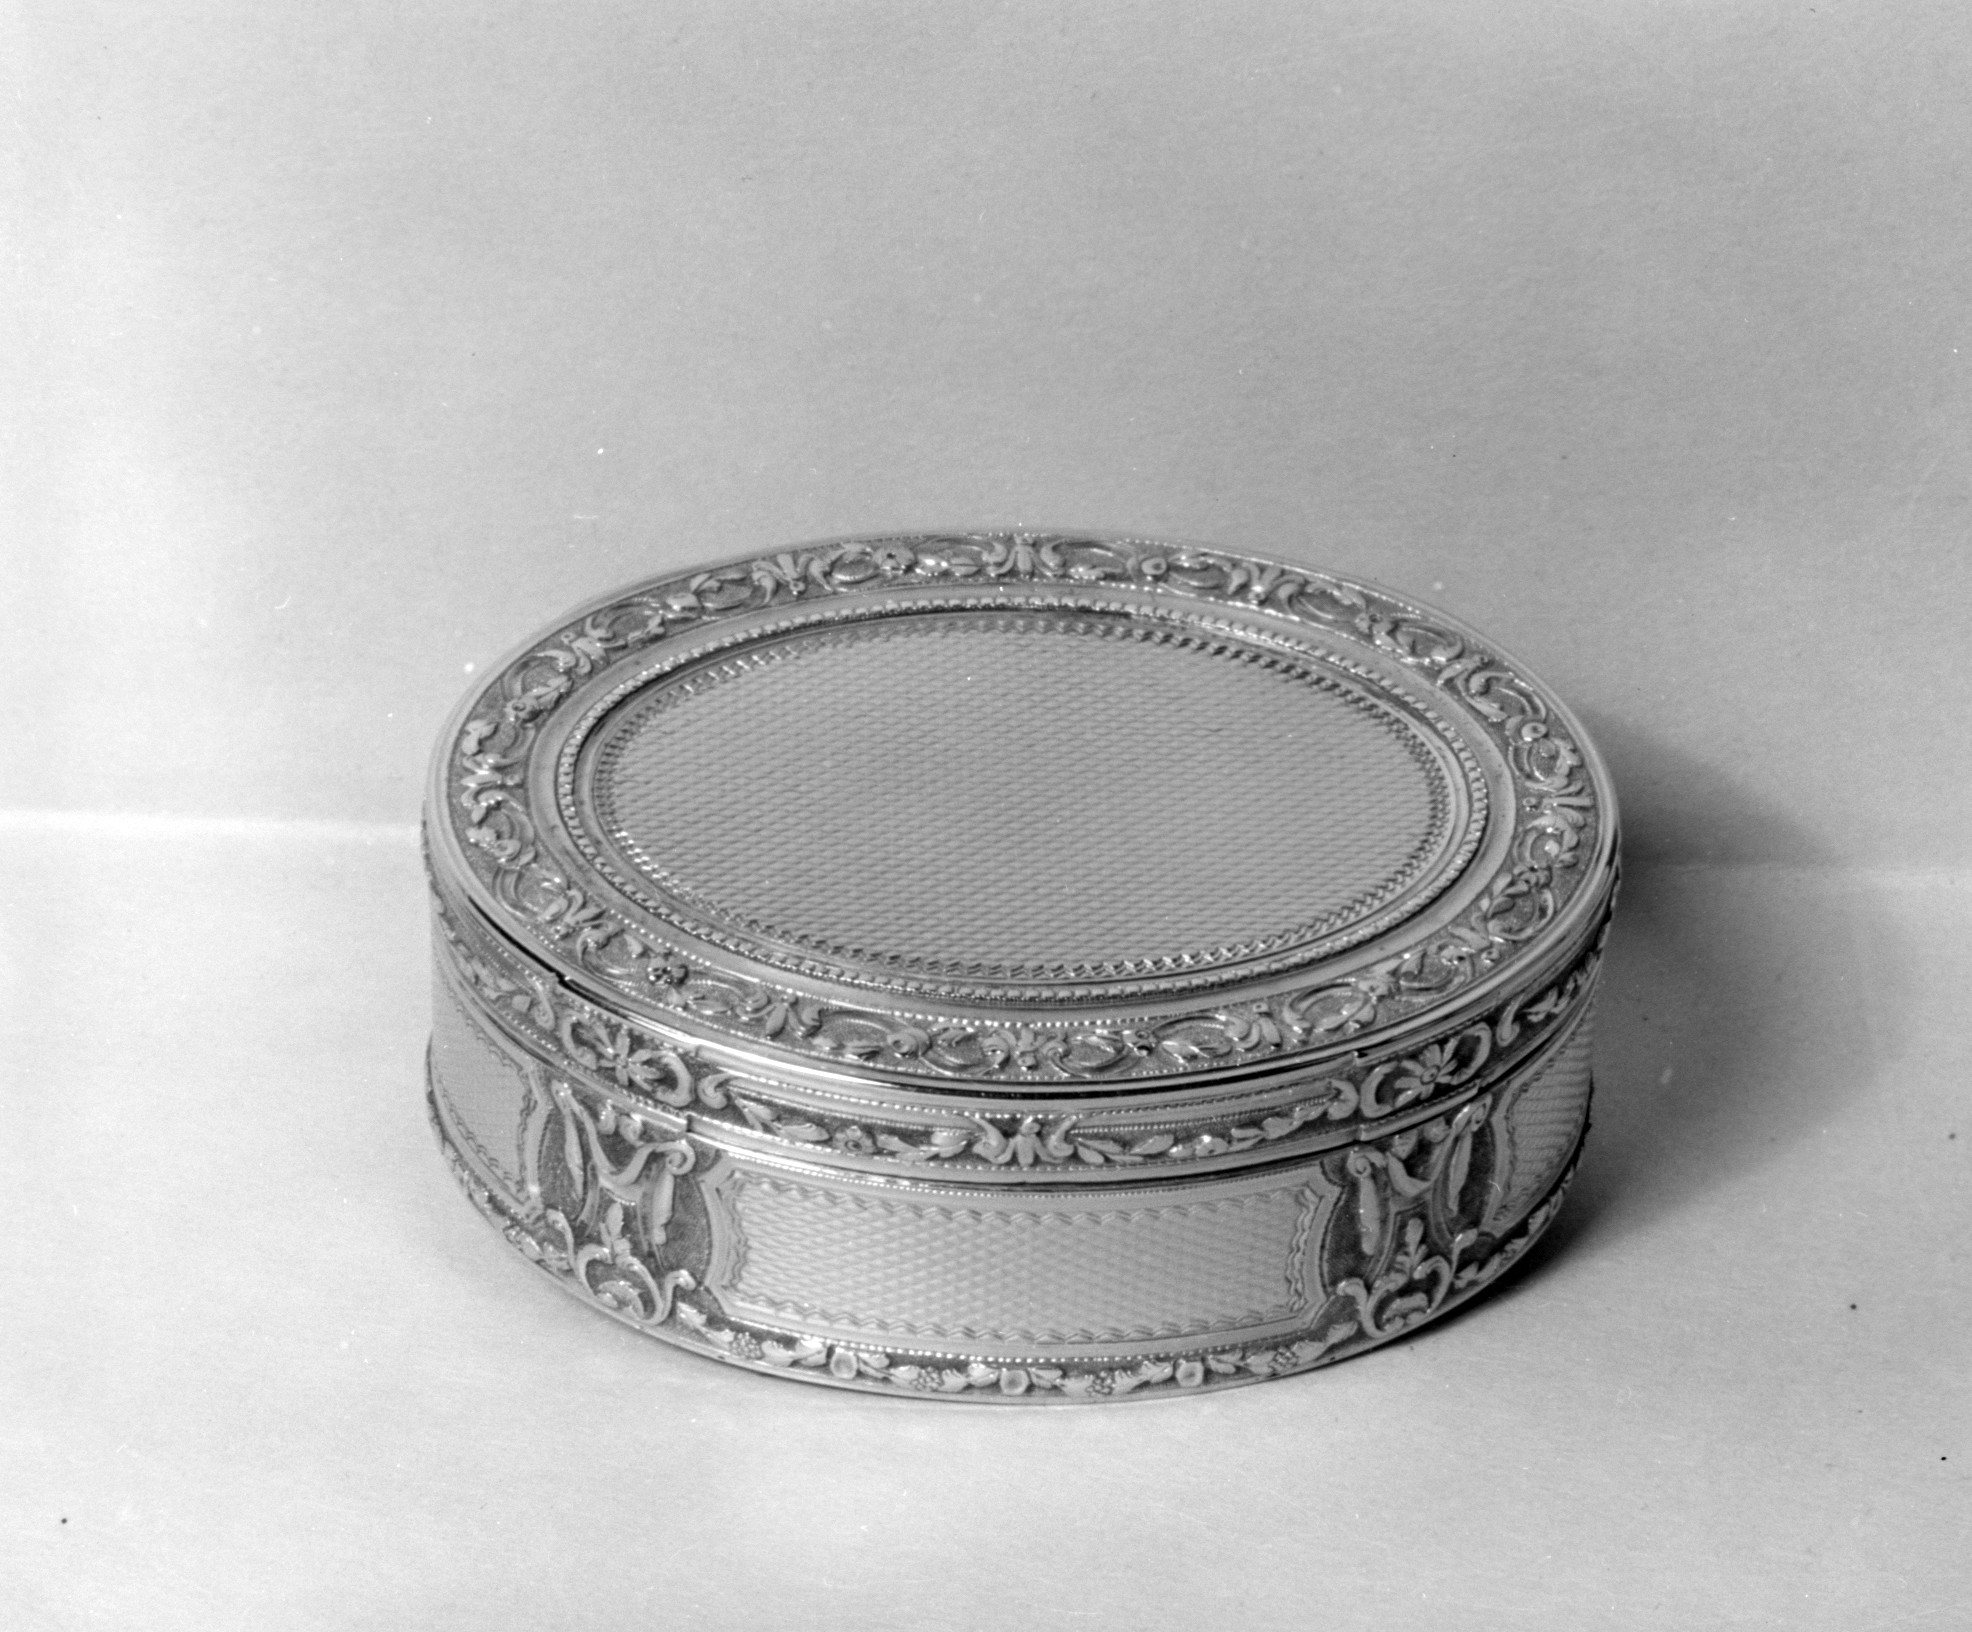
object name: box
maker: claude-françois thierry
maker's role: maker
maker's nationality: french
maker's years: 1745-1845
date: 1779-1780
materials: gold